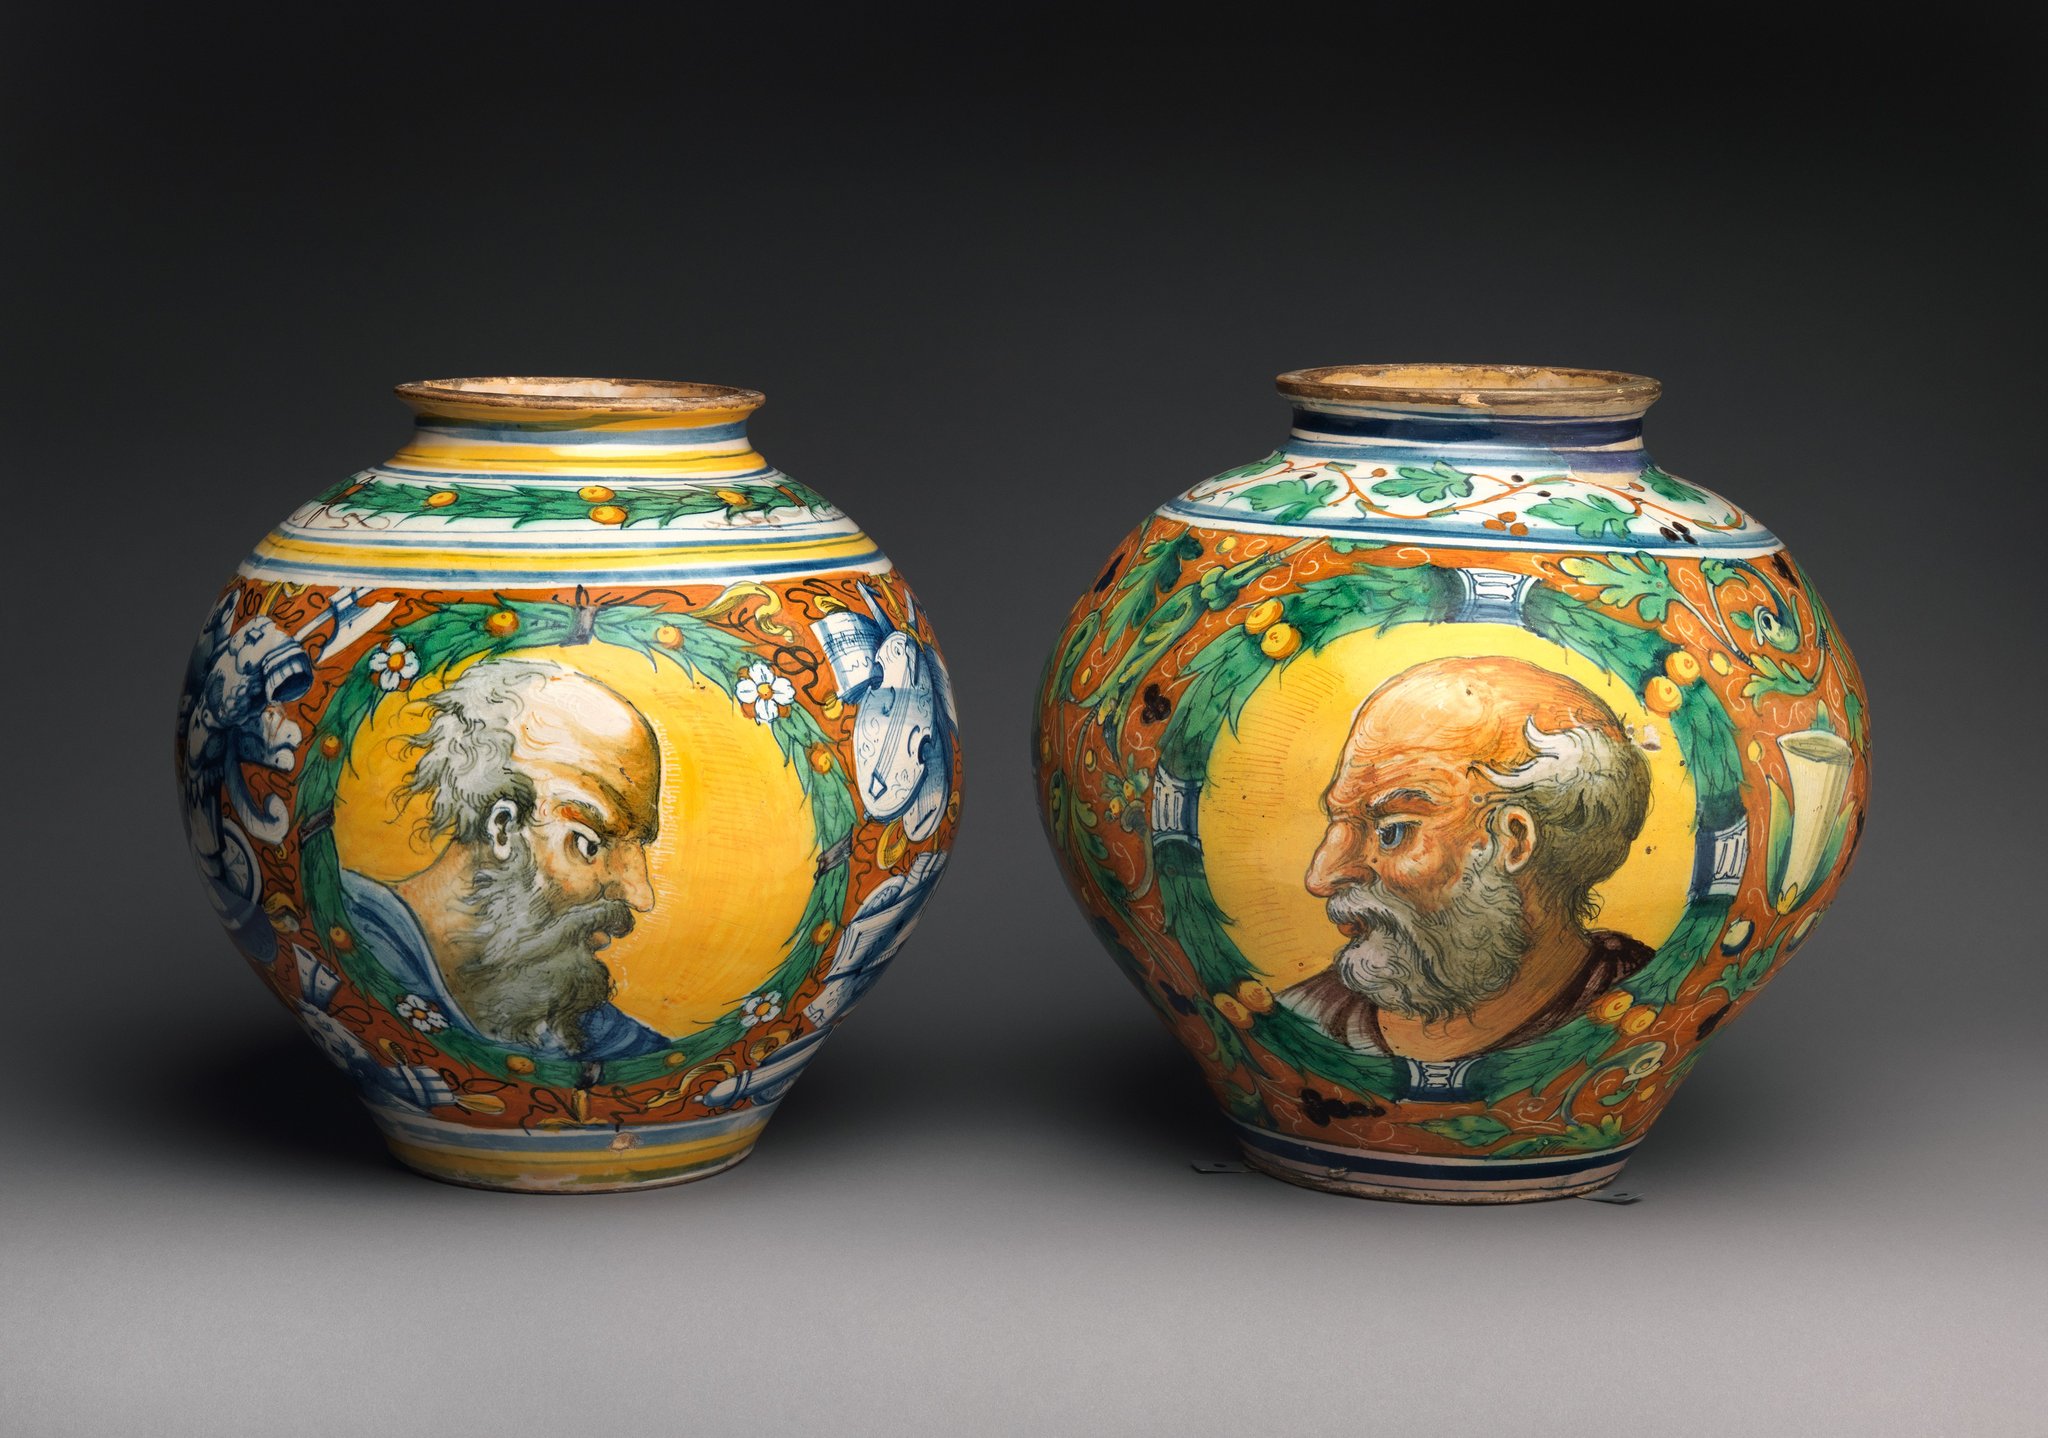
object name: storage jar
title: Storage jar (one of a pair)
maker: domenico veneziano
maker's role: maker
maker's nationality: italian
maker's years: 1438-1461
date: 1550-1570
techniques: maiolica, glazing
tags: profiles